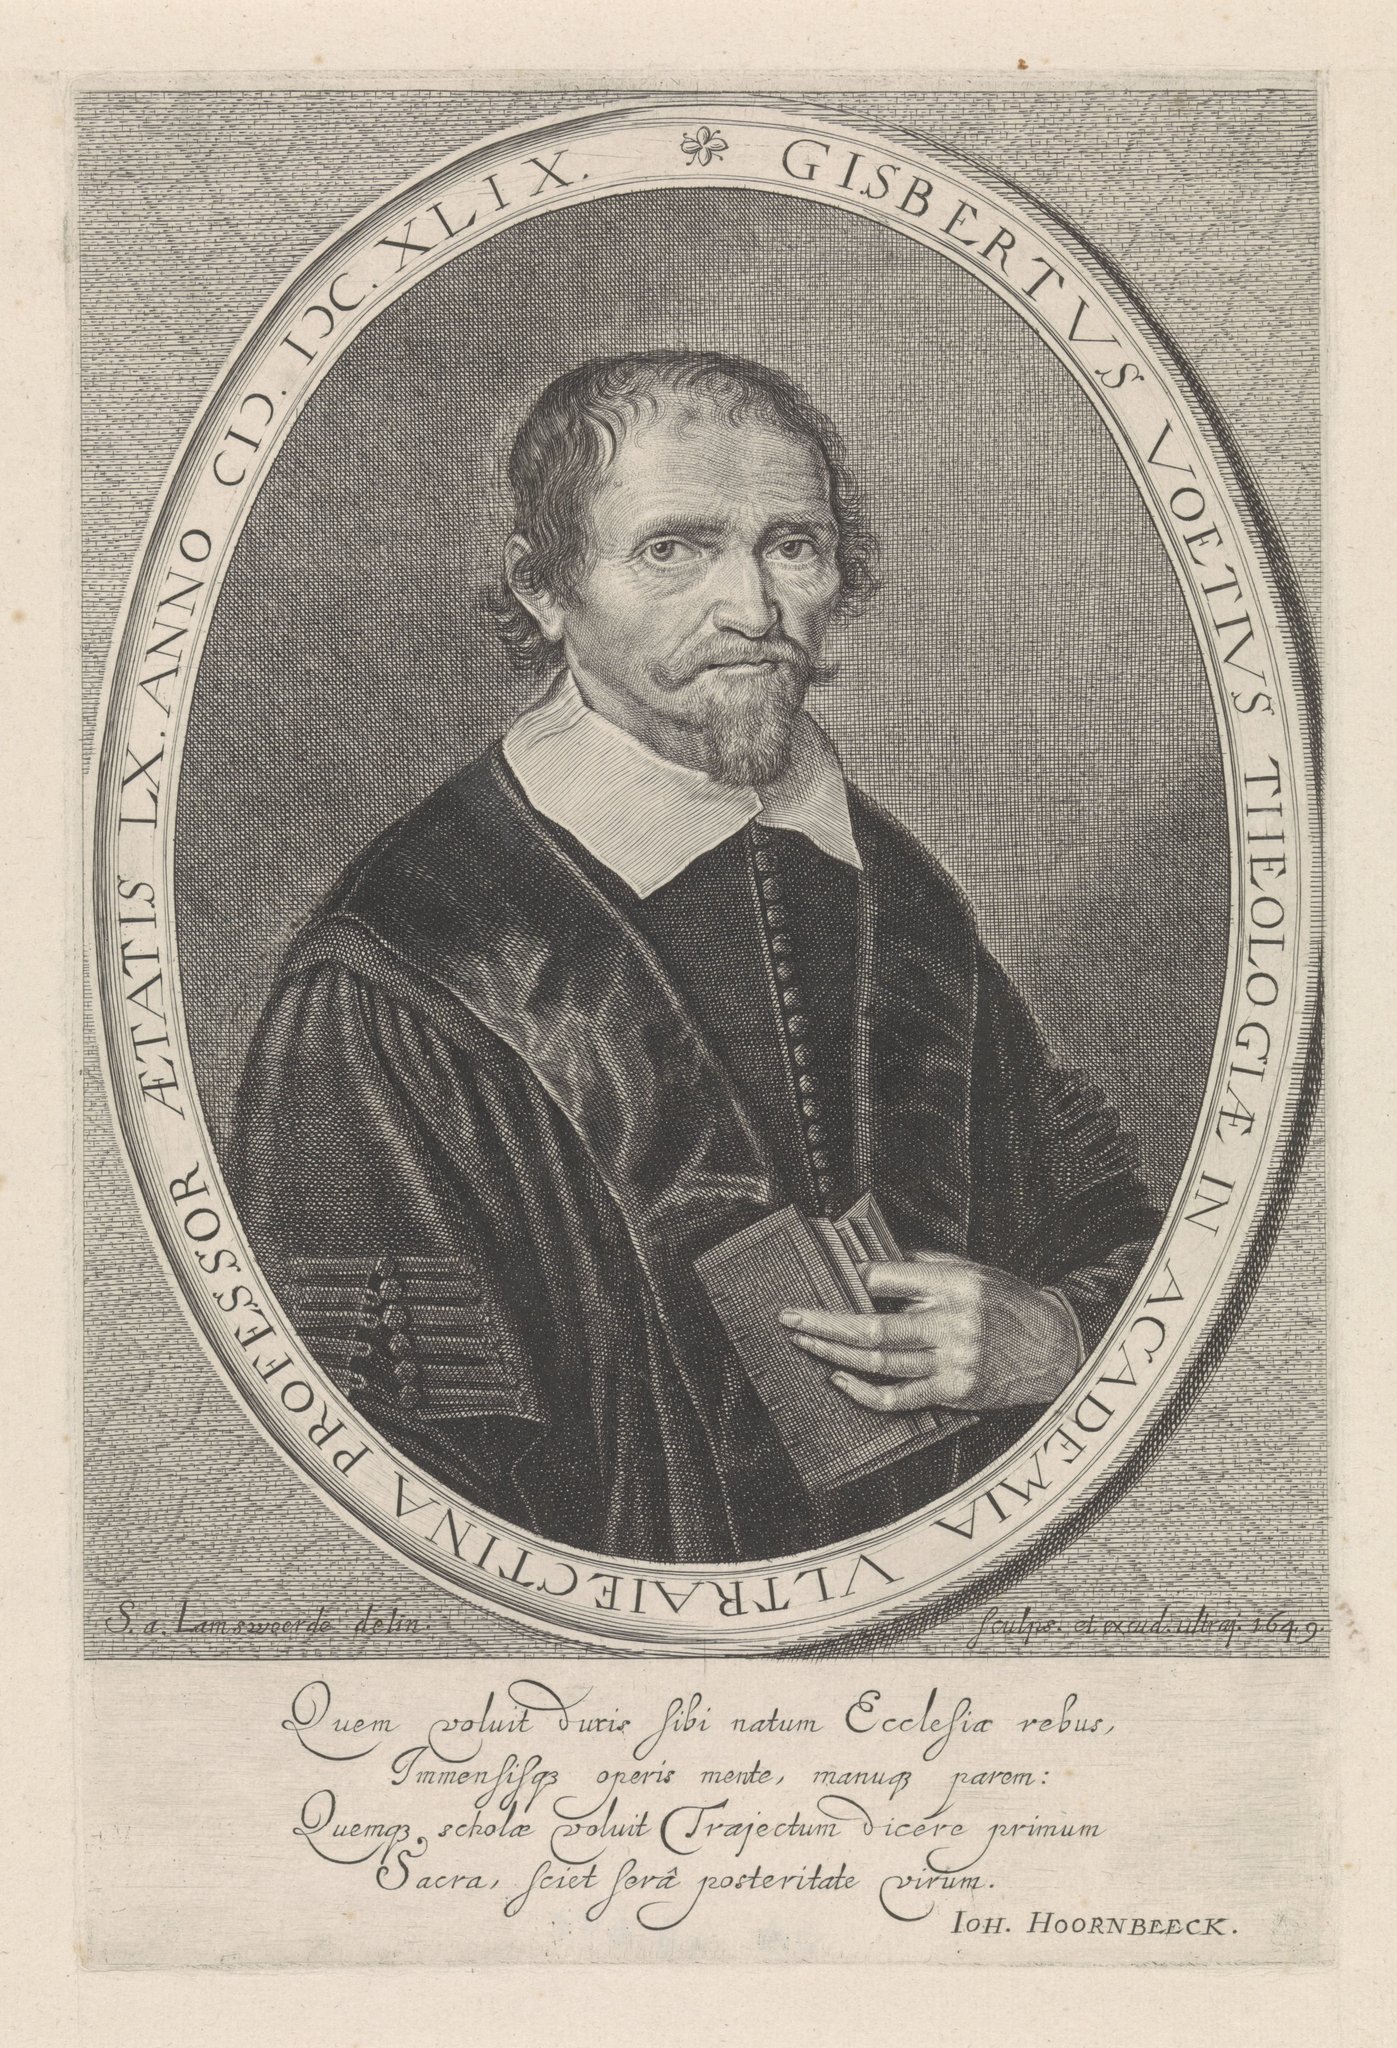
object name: print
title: Portret van Gisbertus Voetius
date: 1649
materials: paper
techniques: engraving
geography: utrecht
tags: utrecht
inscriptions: collector's mark: Lugt 240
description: Portretbuste in ovaal naar rechts van Gisbertus Voetius, predikant en hoogleraar in de theologie te Utrecht, blootshoofds. In zijn linkerhand houdt Voetius een boek. Op de ovale omlijsting staat een randschrift in Latijn, in de marge een vierregelig Latijns vers.